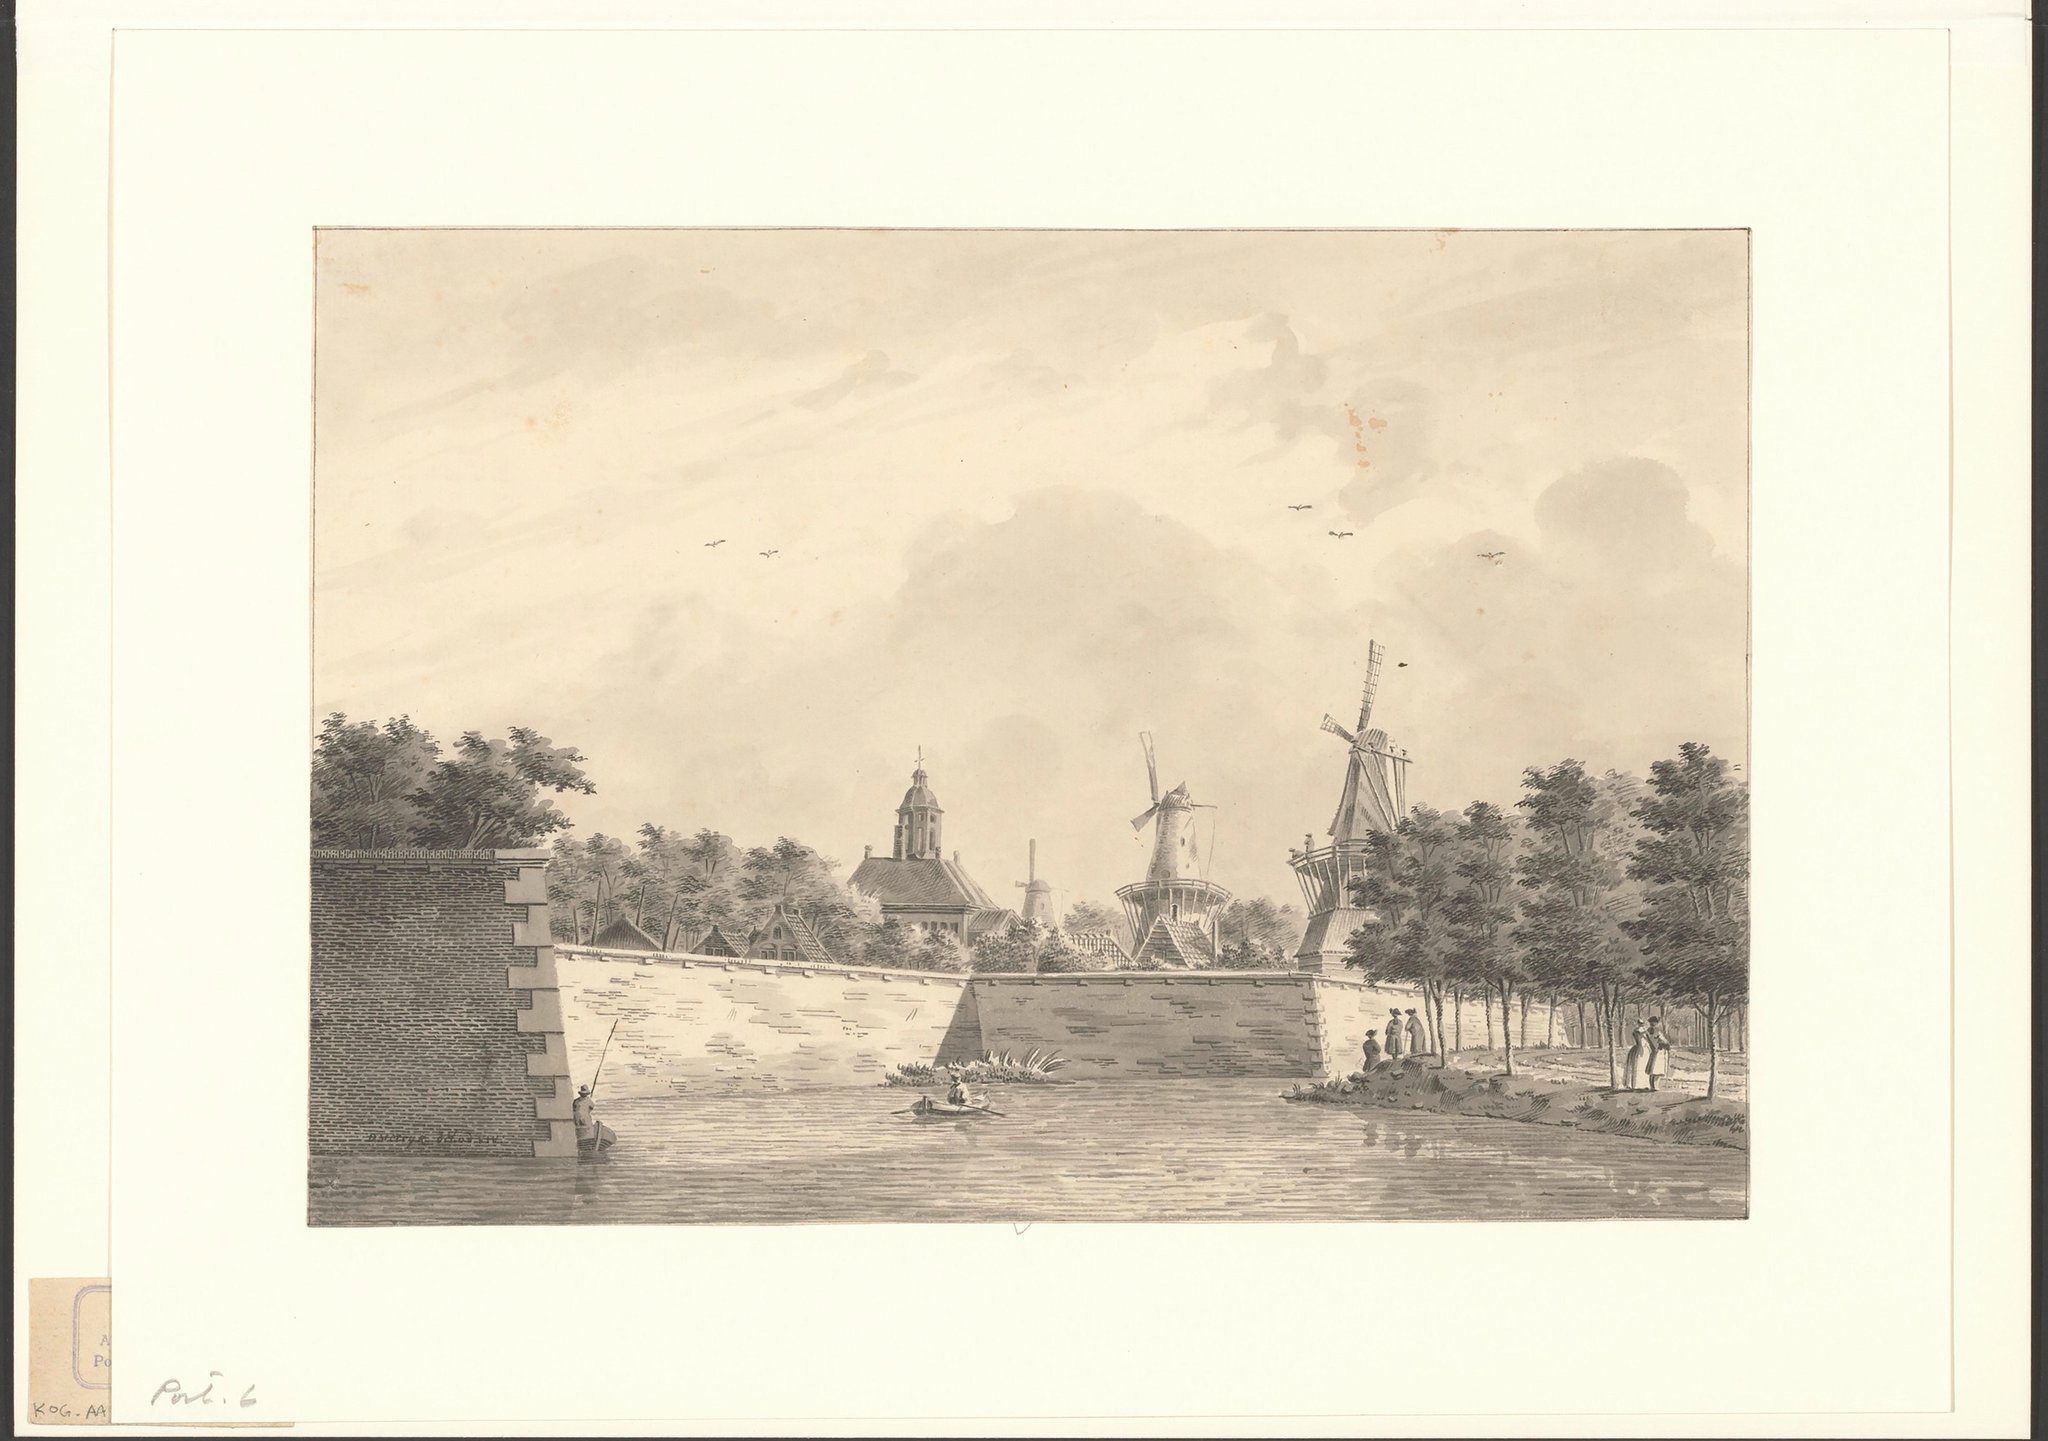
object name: drawing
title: Gezicht op het Singel tussen de Weteringpoort en de Utrechtsepoort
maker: dirk verrijk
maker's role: draughtsman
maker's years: 1734-1786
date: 1744-1786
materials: ink, paper, pencil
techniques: brush, pen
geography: amsterdam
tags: city-view in general; 'veduta', river, windmill in landscape, city-walls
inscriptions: inscription: ‘Port. 6’, signature: ‘D.Verryk del.ad.viv.’, collector's mark: ‘6’ Lugt 1641b, inscription: ‘tusschen de Weteringpoort / de utrechtsche poort te zien aen d' oostzyde’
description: Onderwerpsrubriek binnen de Atlas Amsterdam: Buitensingel of wel: Gezichten langs en op de Stadsvest van Raampoort tot Zeeburgerdijk.